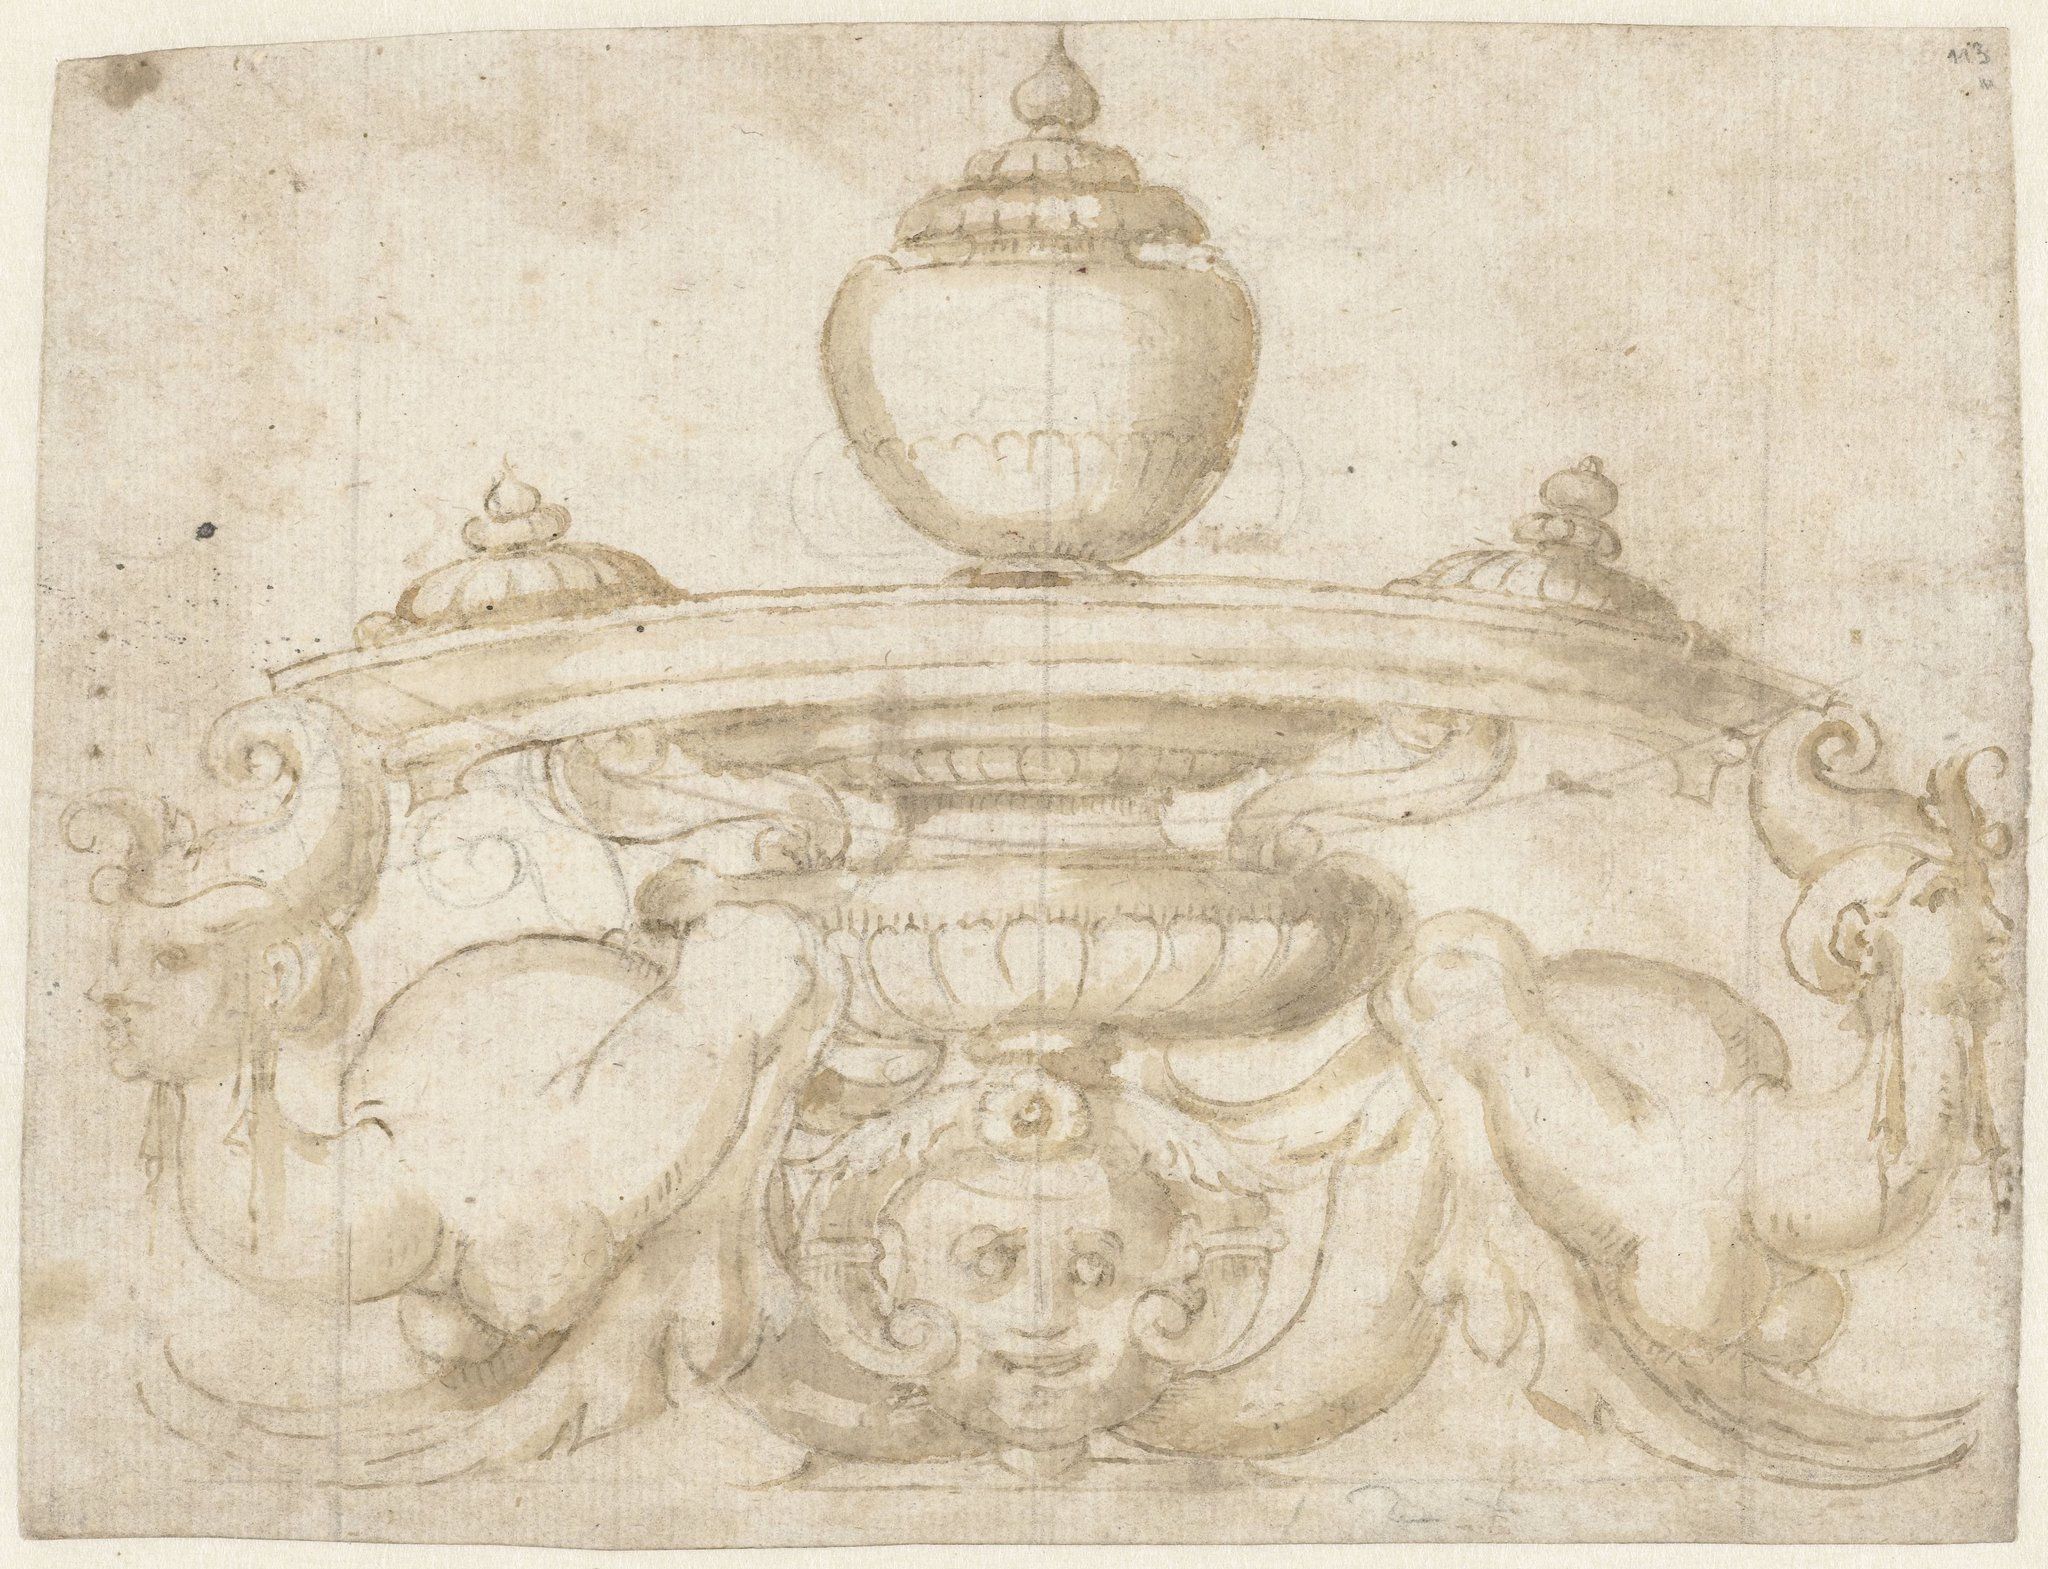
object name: drawing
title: Vaasmotief geschraagd door twee najade-achtige figuren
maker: andrea di cosimo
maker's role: draughtsman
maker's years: 1477-1548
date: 1487-1548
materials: chalk, paper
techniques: brush, pen, drawing